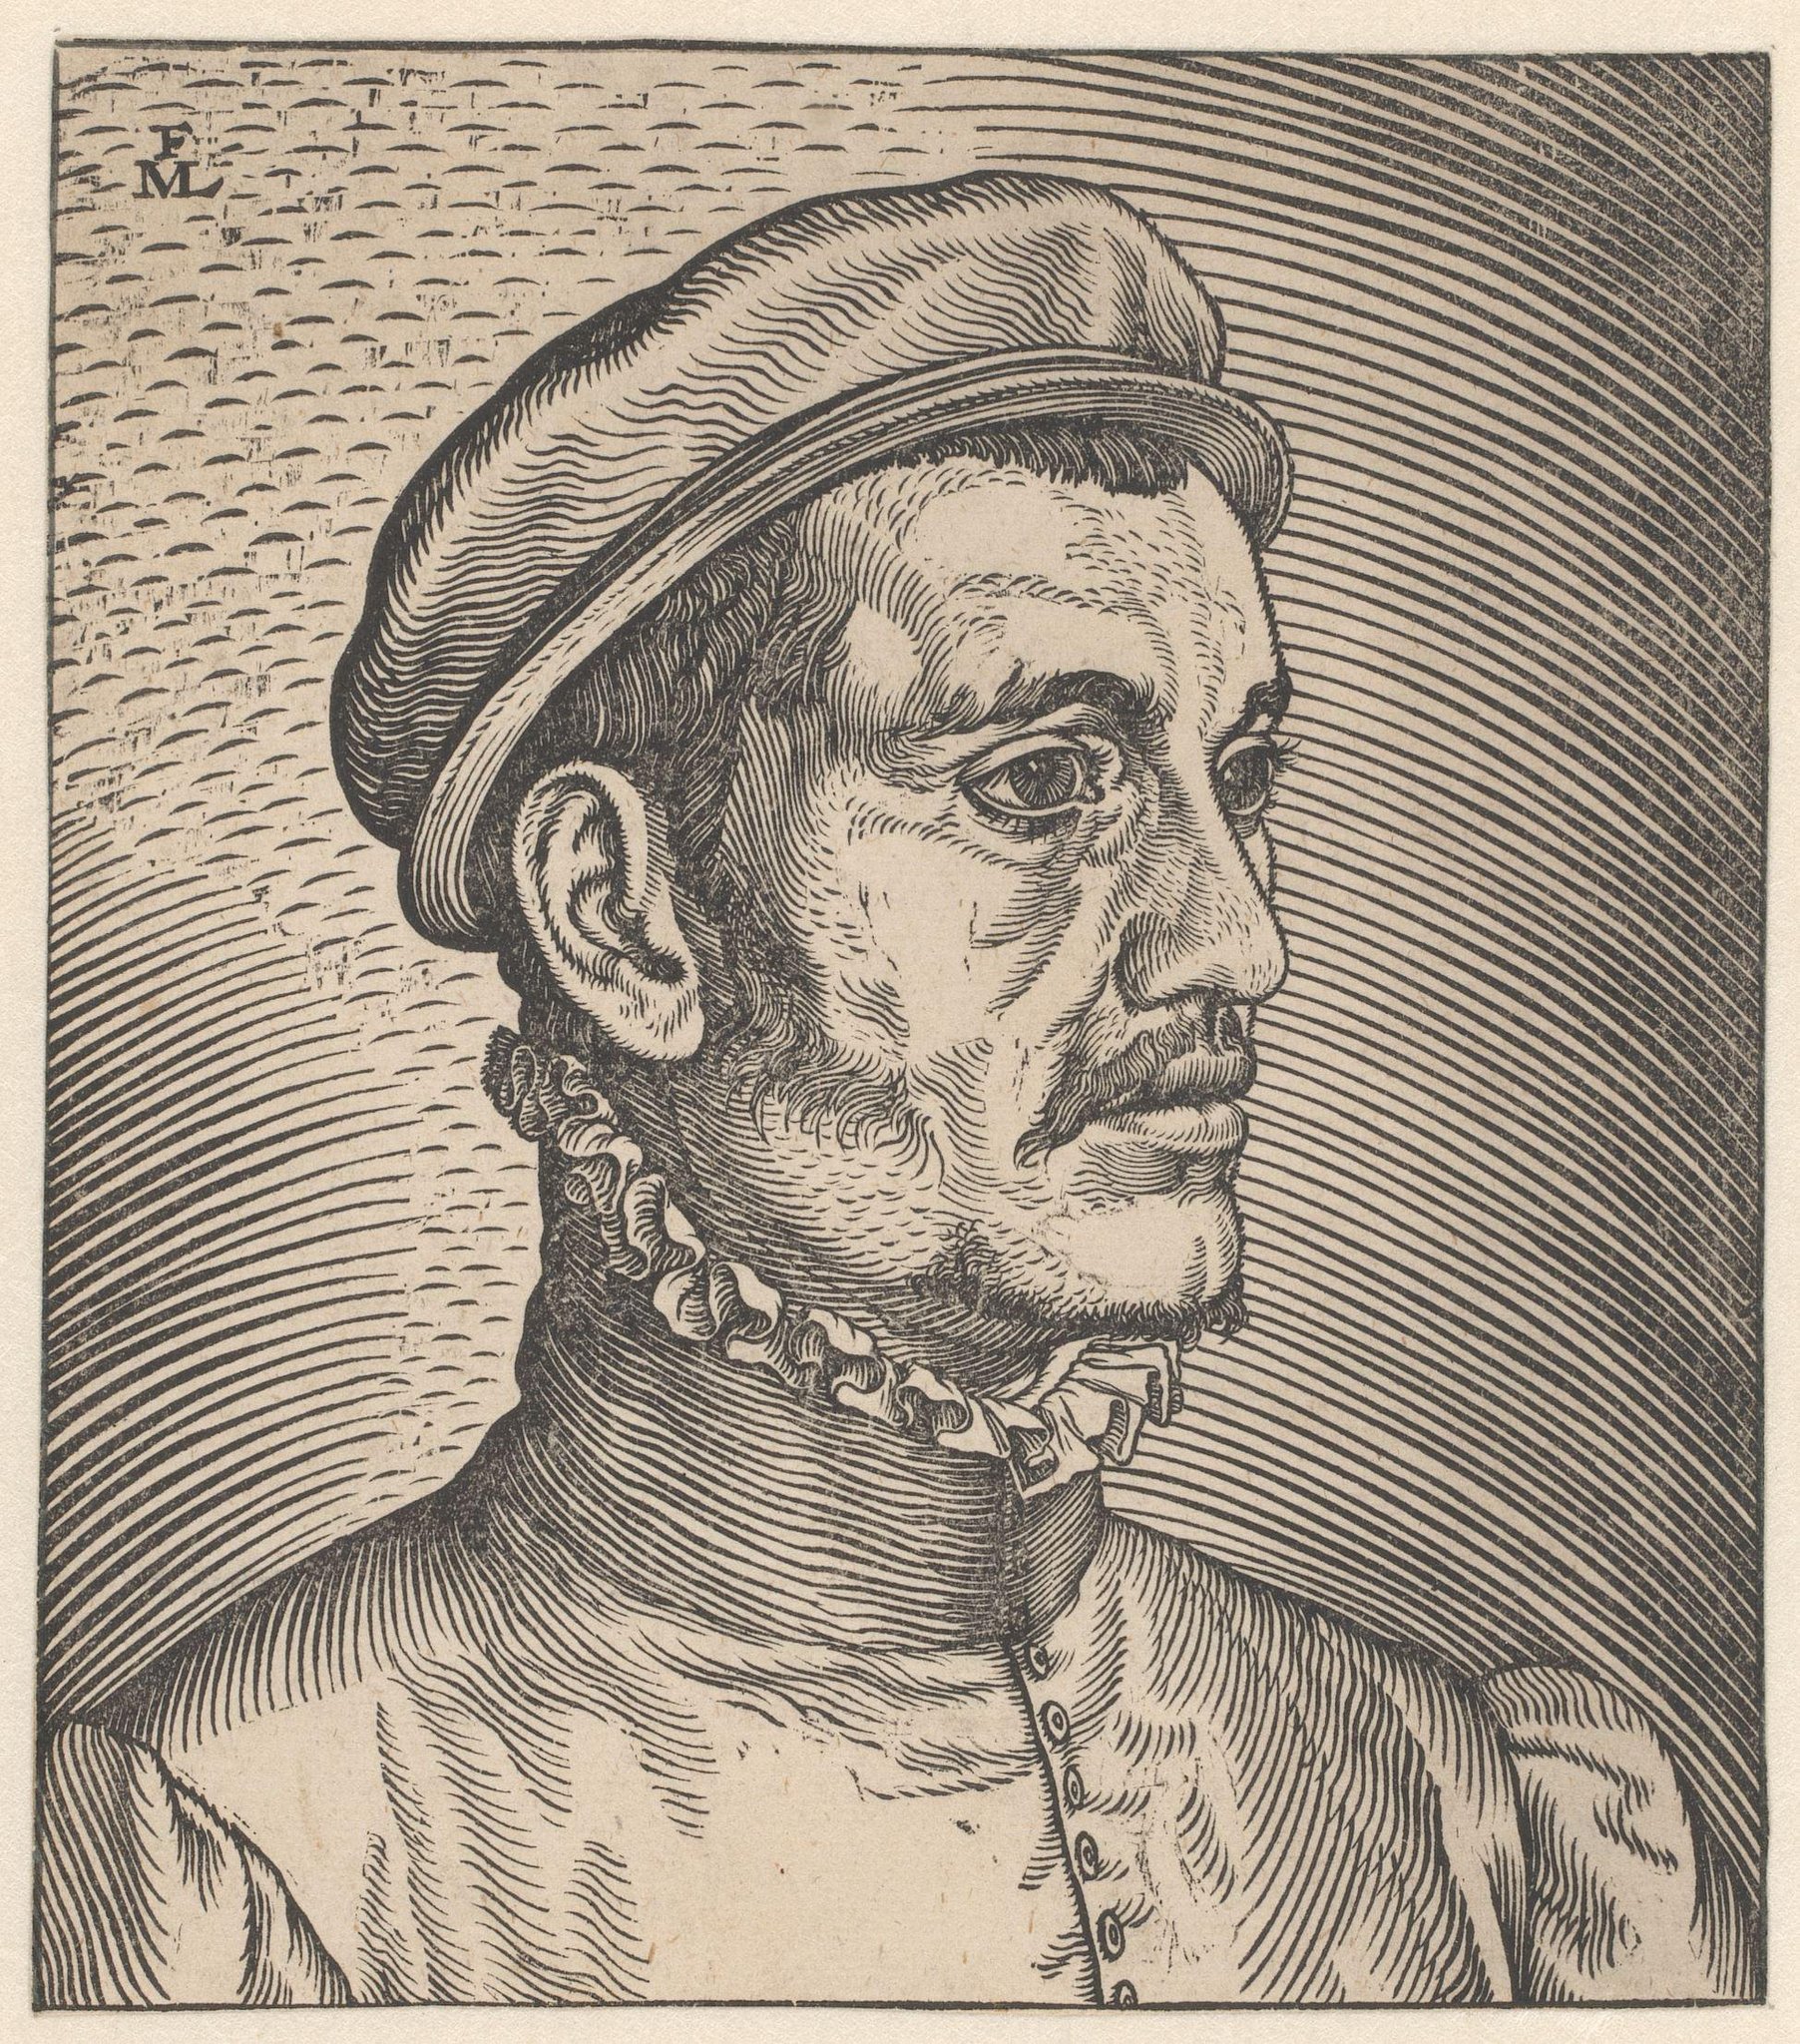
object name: print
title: Young man wearing a cap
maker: melchior lorck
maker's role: draughtsman, painter, print maker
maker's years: 1526-1588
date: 1564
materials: paper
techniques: woodcut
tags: historical persons, head-gear: beret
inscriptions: collector's mark: Lugt 2228, collector's mark: ‘DC’, collector's mark: Lugt 2760, collector's mark: Lugt 269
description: Portret van een jonge man met baret. Mogelijk portret van de schrijver Andreas Charopus.